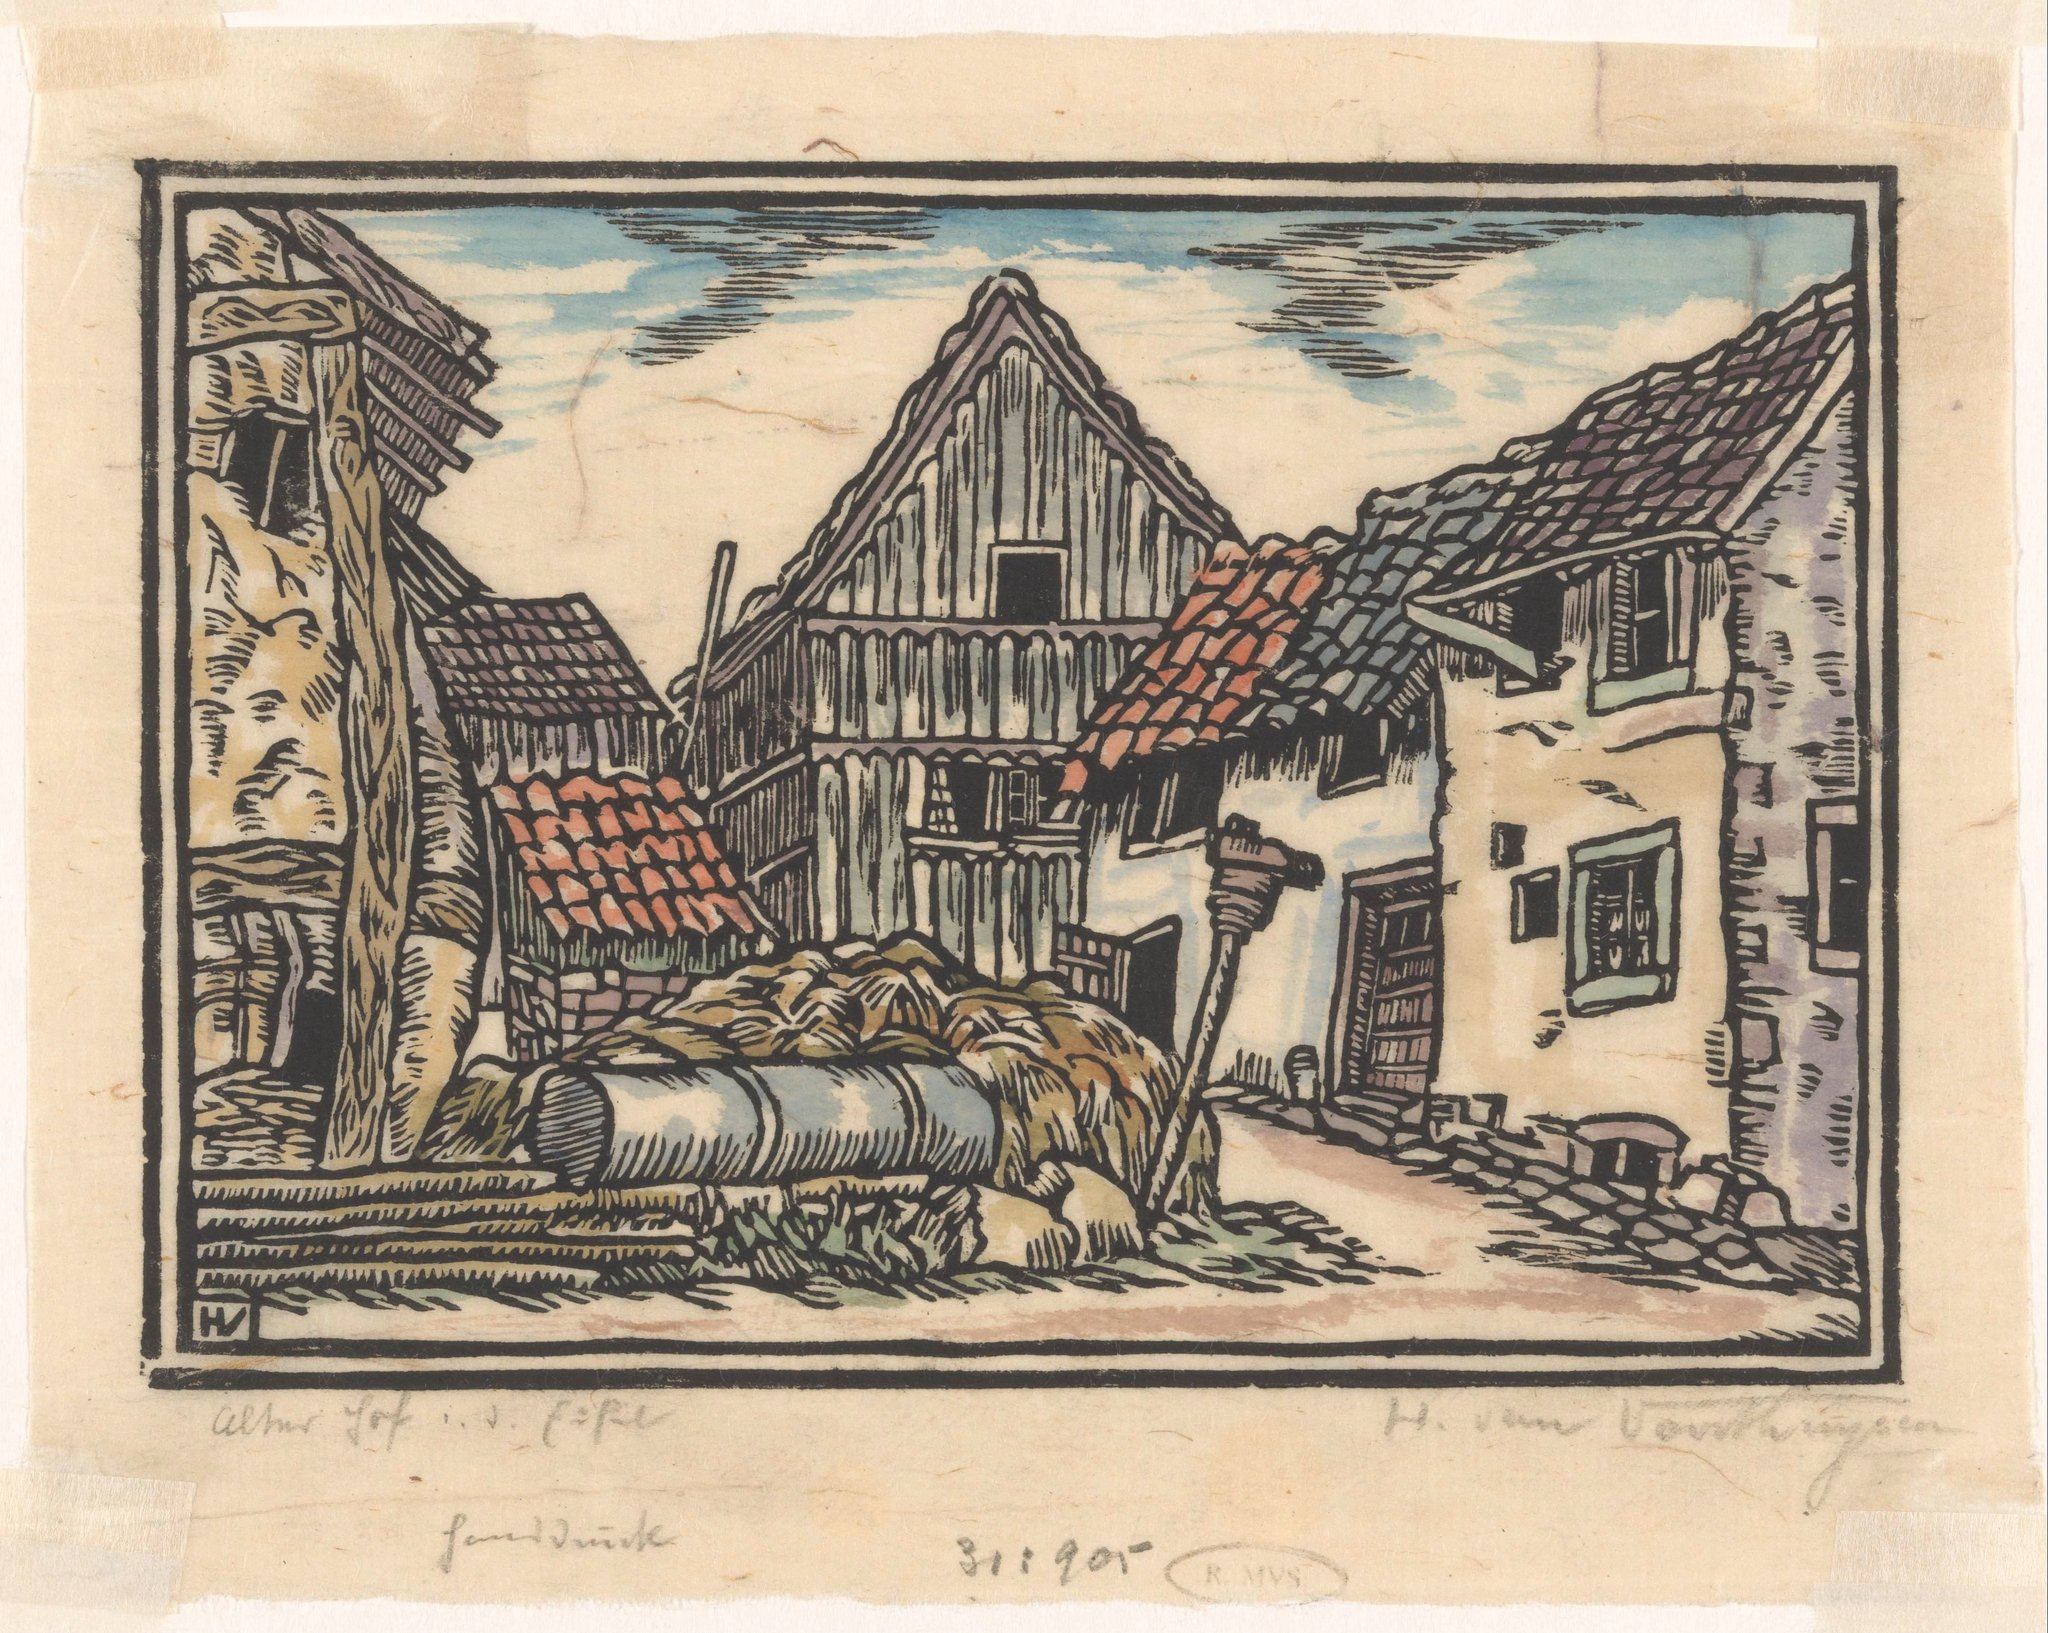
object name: print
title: Boerderij in de Eifel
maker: henriëtte van hove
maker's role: print maker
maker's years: 1861-1918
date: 1871-1918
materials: paper, watercolor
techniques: hand coloring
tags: farm (building)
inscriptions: collector's mark: Lugt 2228